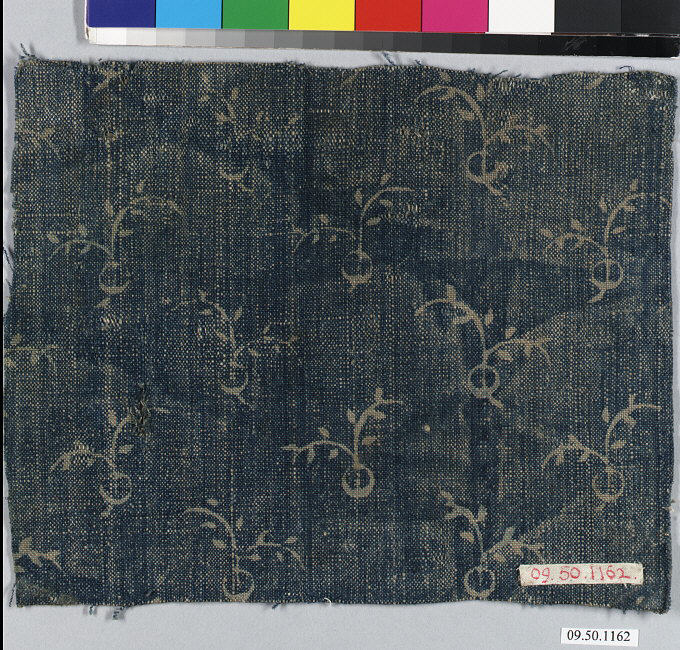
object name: fragment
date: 1801-1900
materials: linen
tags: leaves